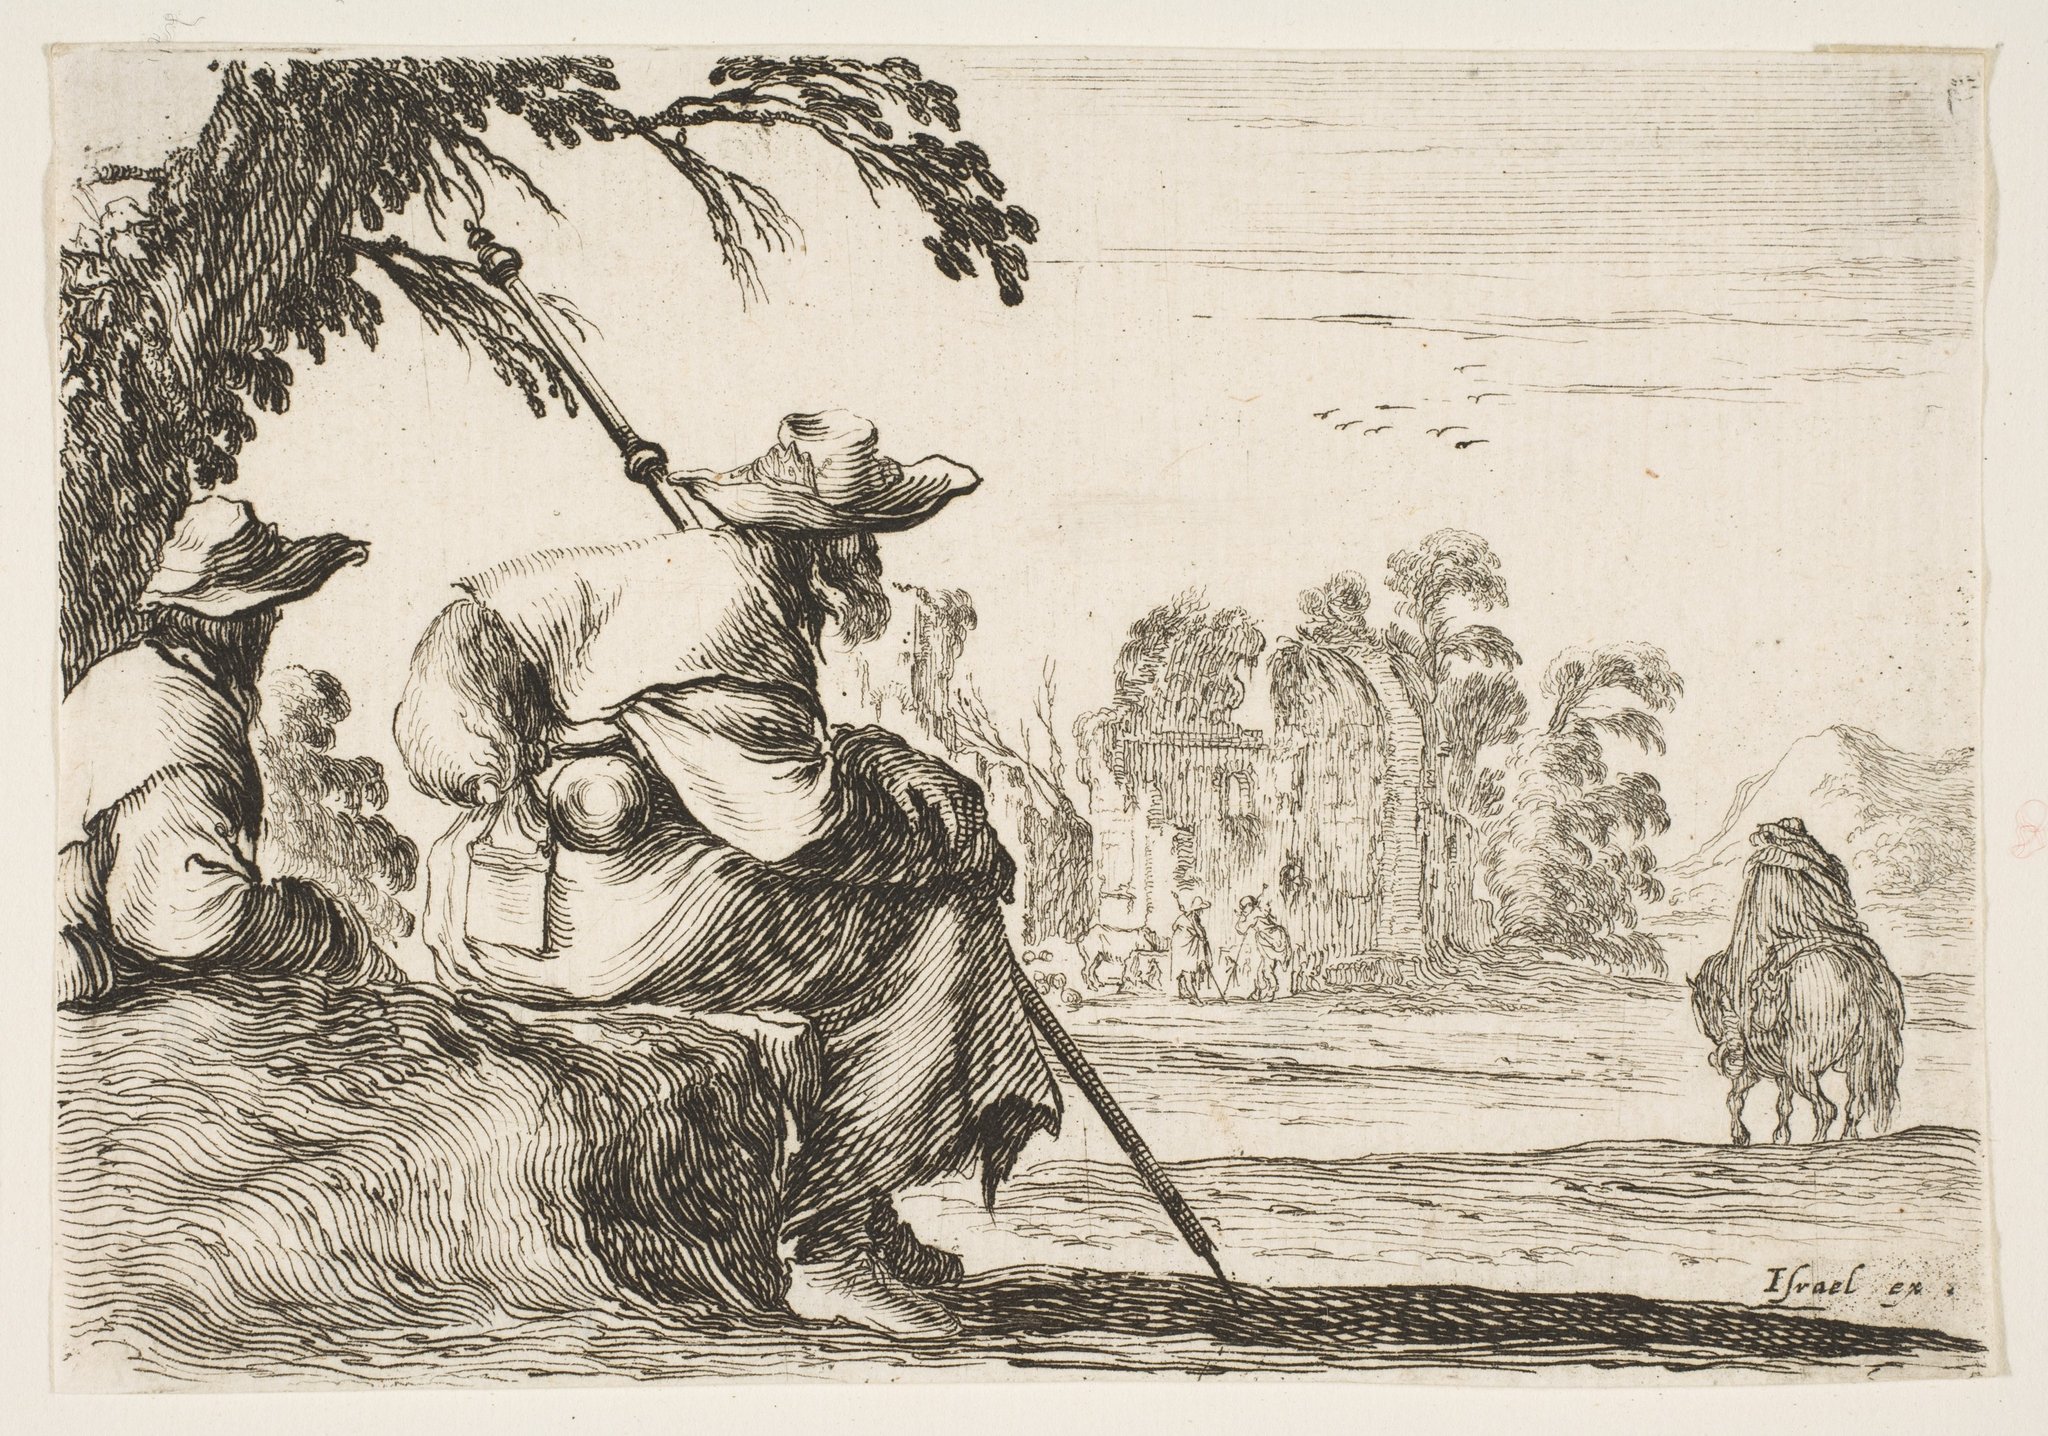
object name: print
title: Two pilgrims with hats rest to the left, seen from behind, a horseman rides towards the background to the right, plate 5 from "Various Figures" (Agréable diversité de figures)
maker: stefano della bella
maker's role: artist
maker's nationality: italian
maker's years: 1610-1664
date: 1642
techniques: etching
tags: hats,men,horses,trees